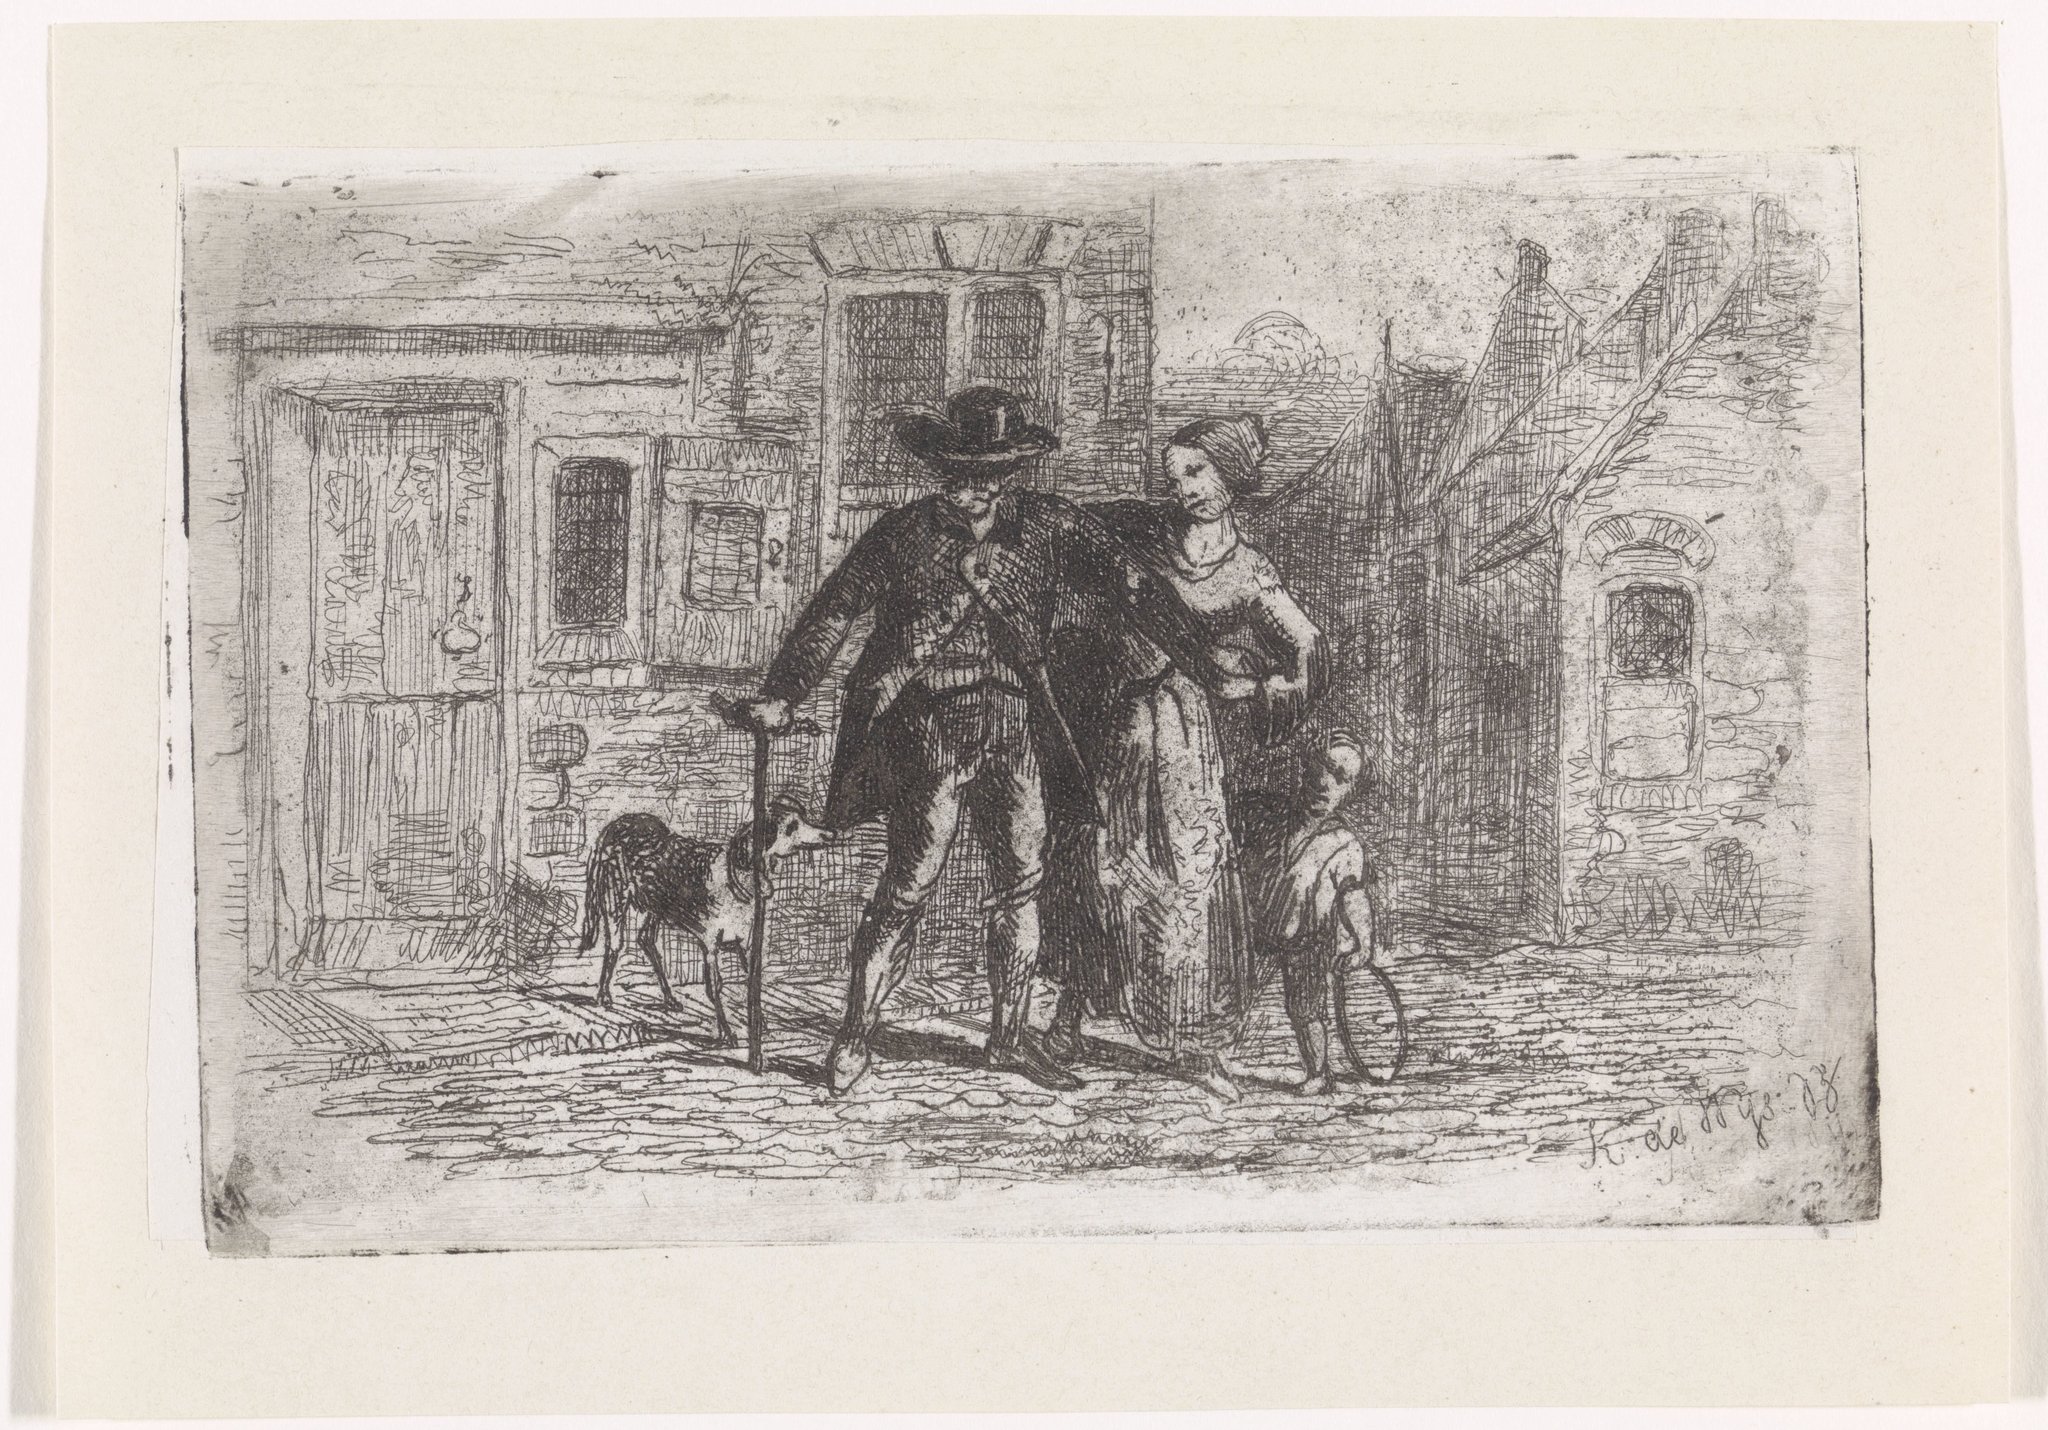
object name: print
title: Vrouw ondersteunt een man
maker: kornelis jzn de wijs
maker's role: print maker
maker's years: 1832-1896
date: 1842-1896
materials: paper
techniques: etching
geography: netherlands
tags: walking-stick, staff, person with a physical disability, village street, dog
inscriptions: collector's mark: Lugt 2228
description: Een vrouw ondersteunt een man met een kruk bij het lopen op straat. Links een hond en naast de vrouw een kind.